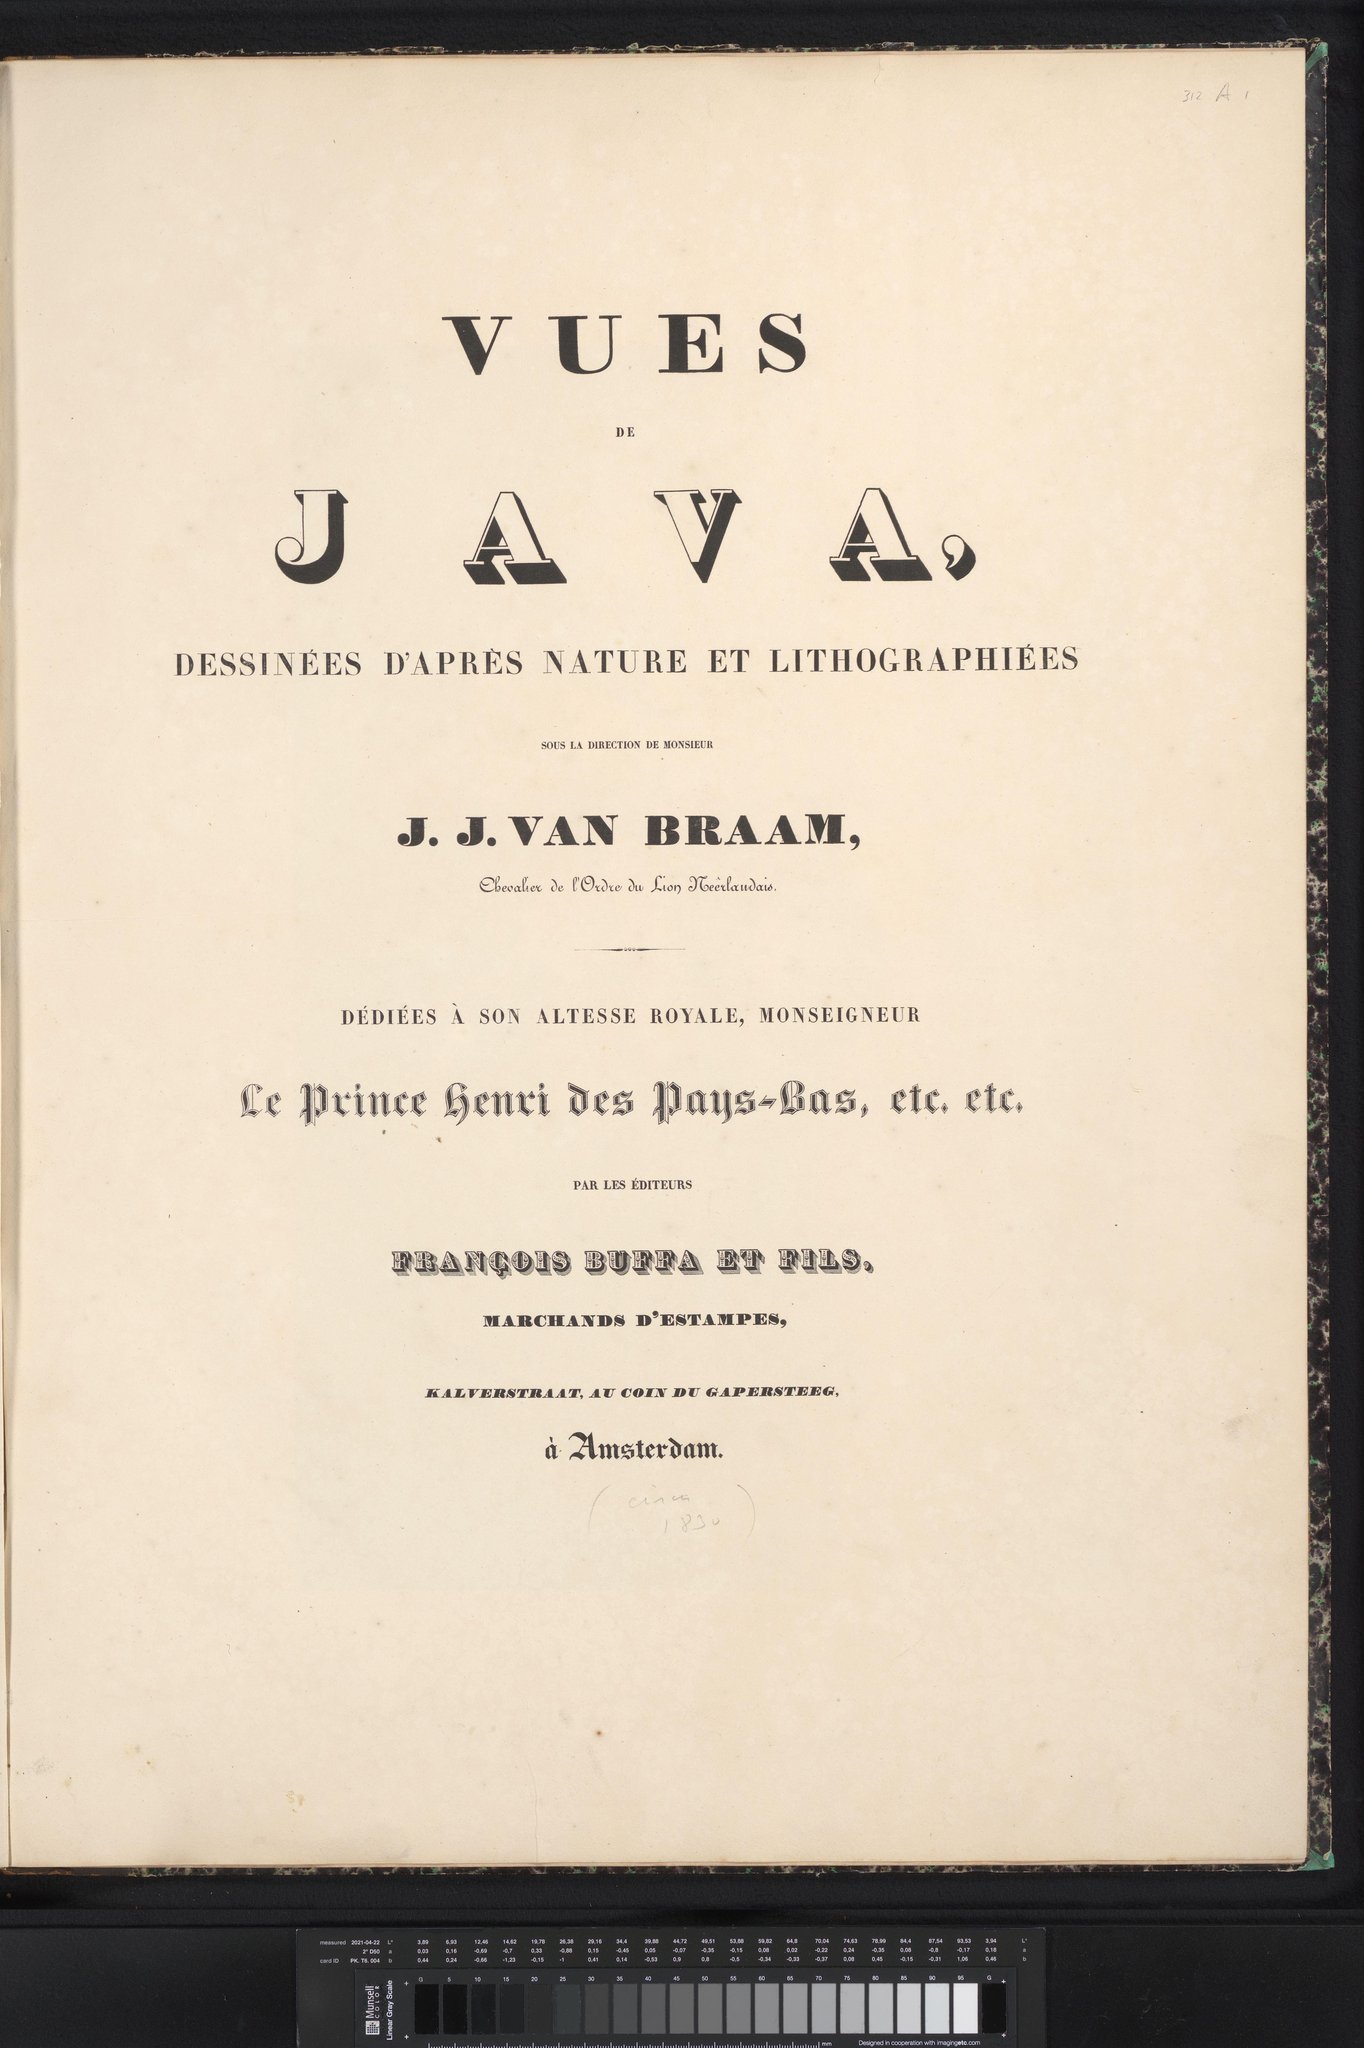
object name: titelprent, frontispice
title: Vues de Java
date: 1822-1845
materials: paper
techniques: lithograph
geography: dordrecht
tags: city-view in general; 'veduta', java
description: Prent maakt deel uit van een album met een serie van zes lithografieën van gezichten te Java en een titelprent.